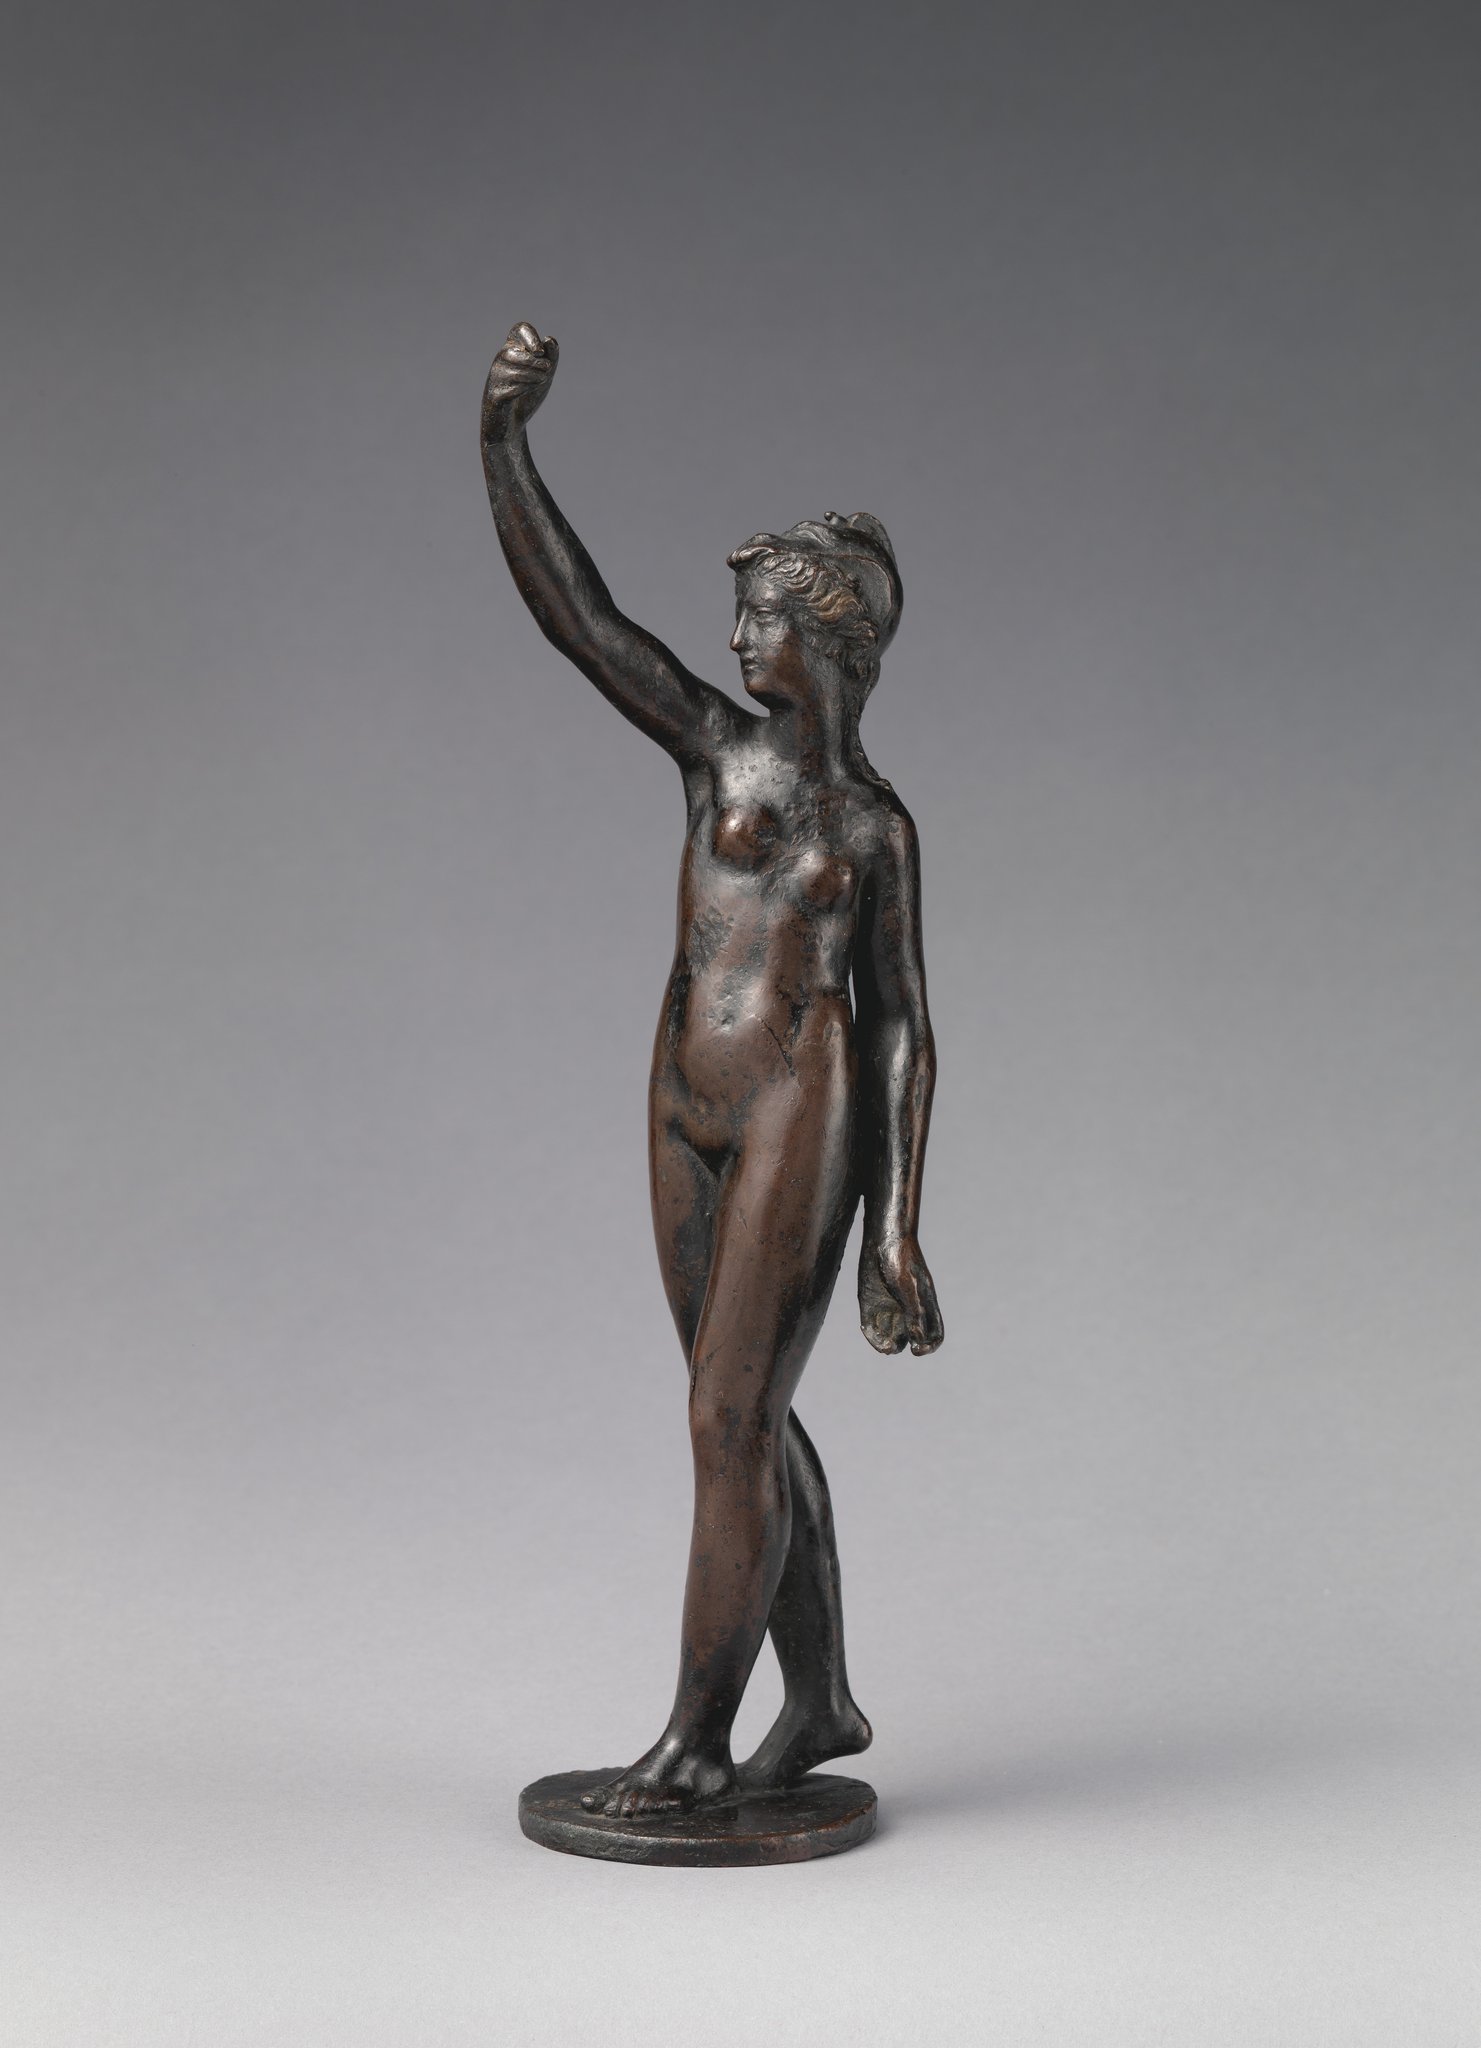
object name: statuette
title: Minerva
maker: benvenuto cellini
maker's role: artist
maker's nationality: italian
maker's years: 1500-1571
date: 1551-1600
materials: bronze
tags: minerva